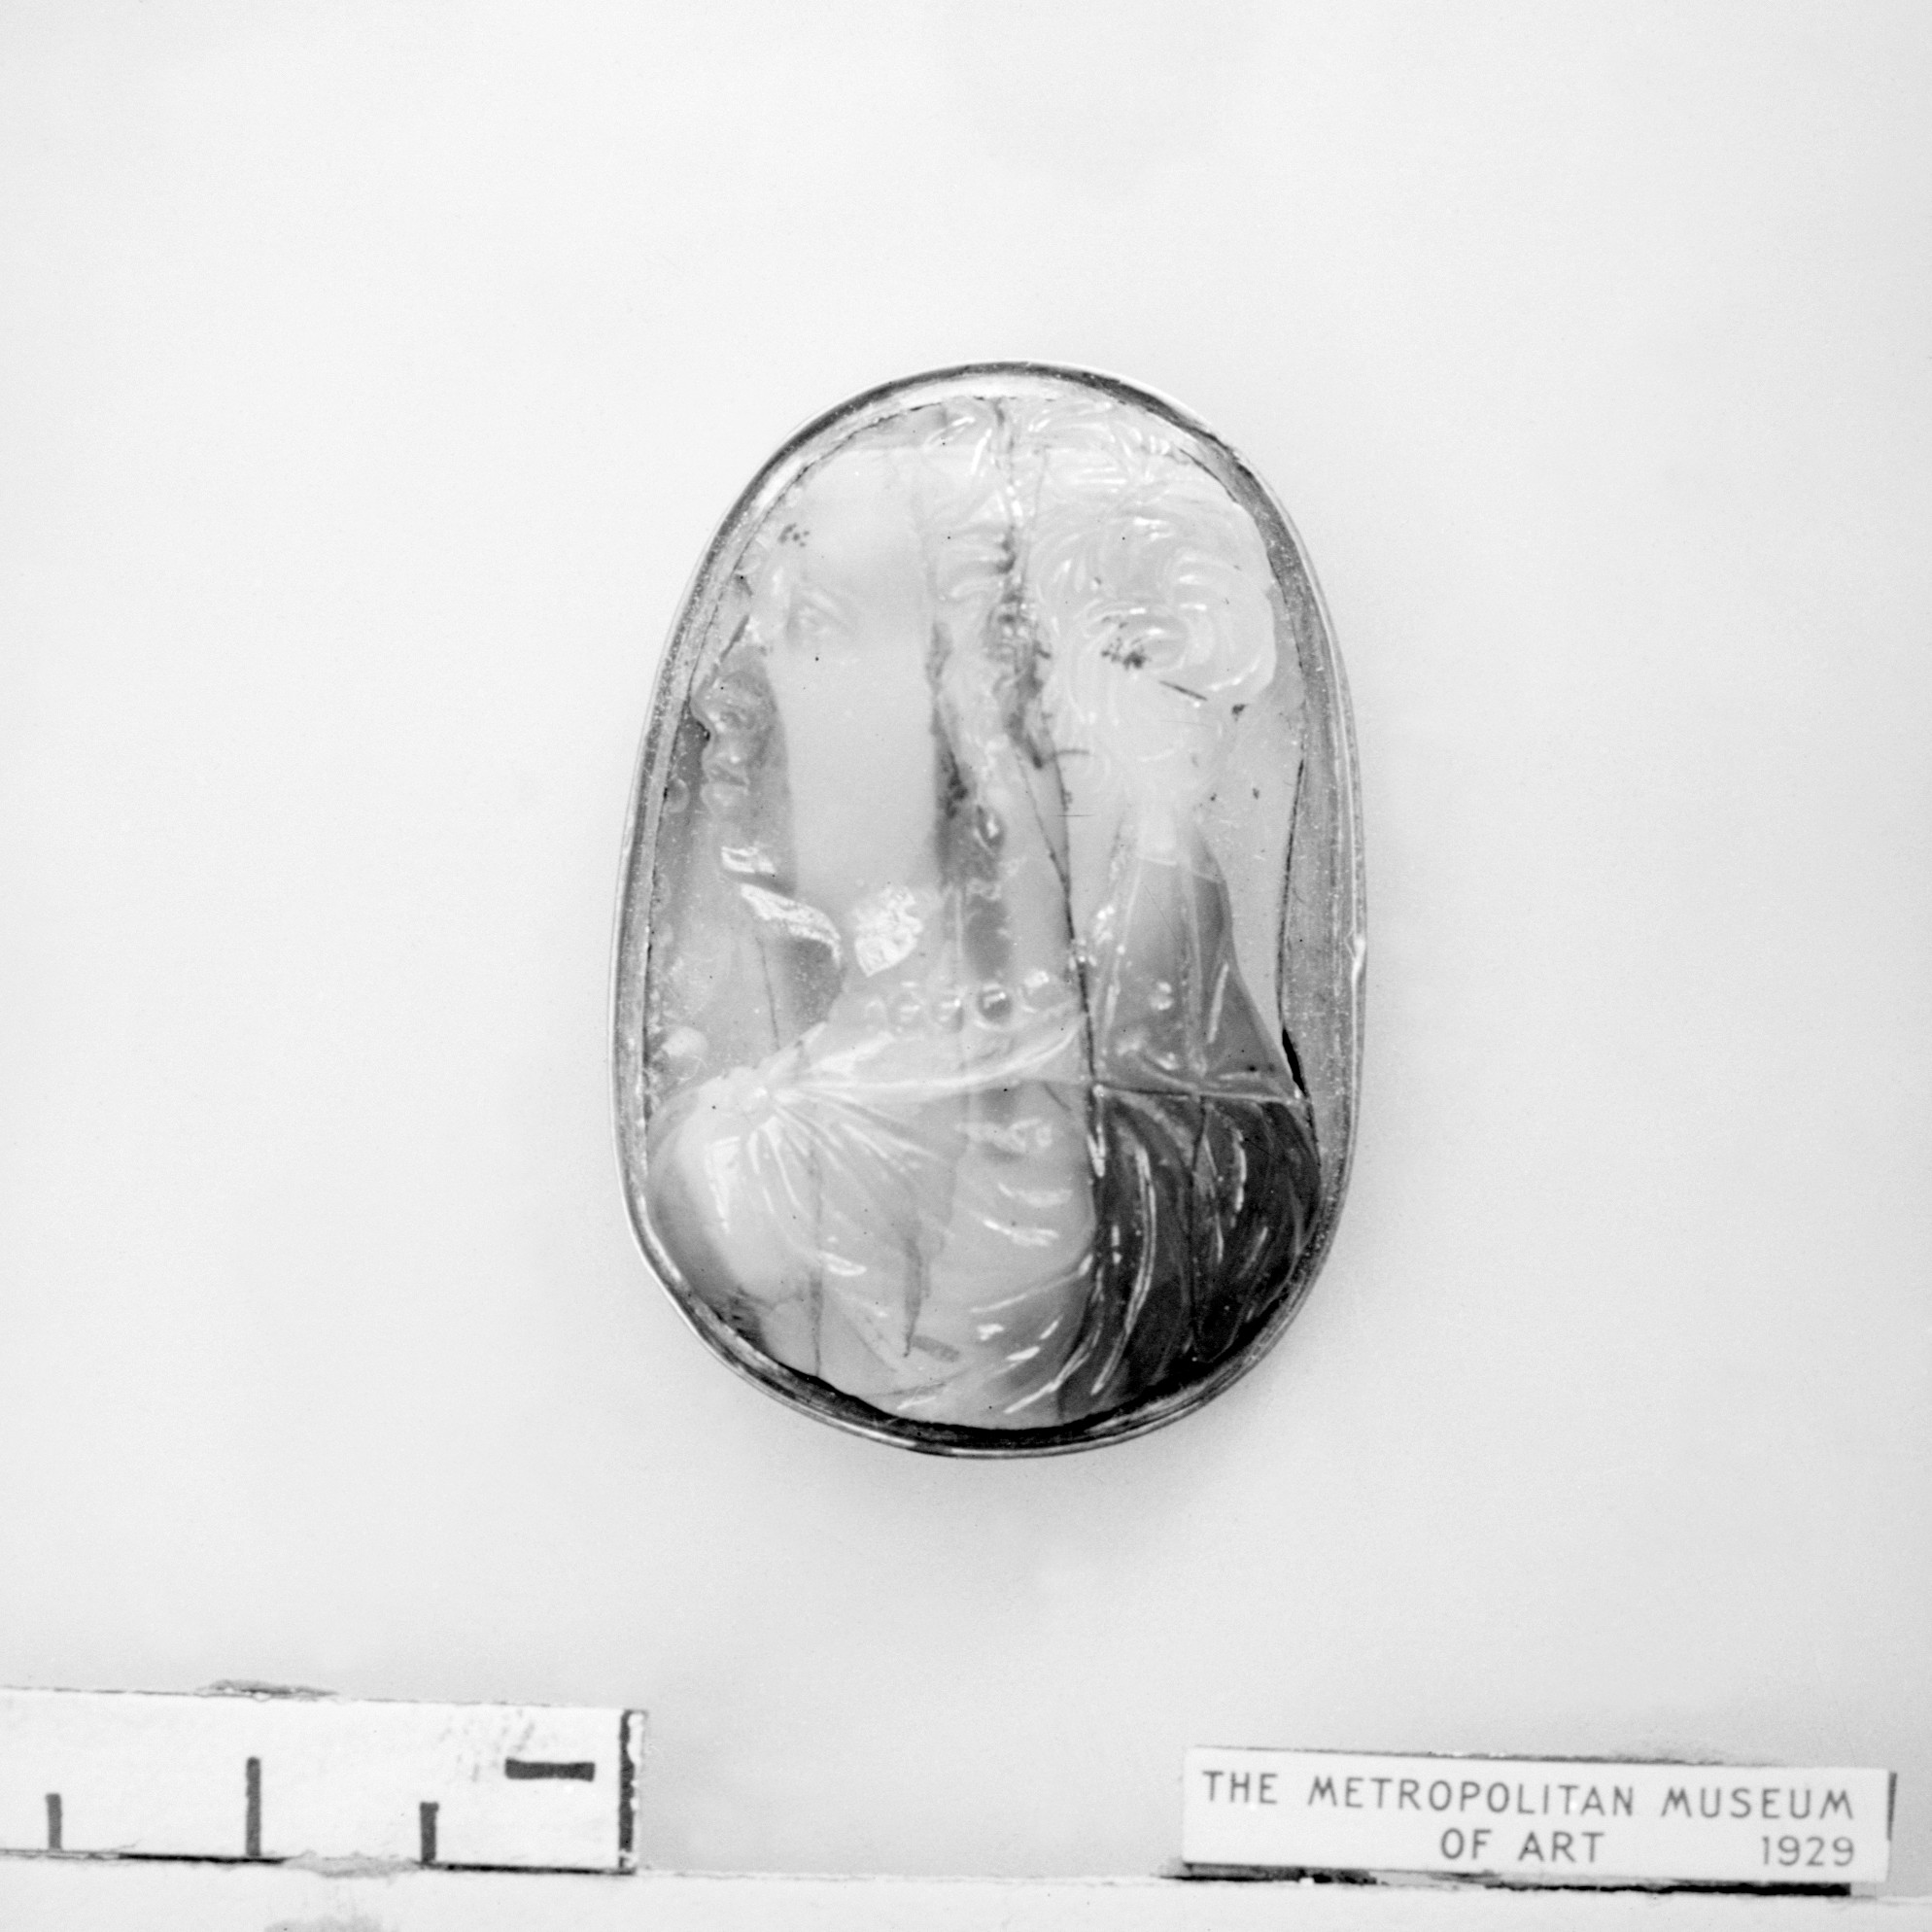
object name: cameo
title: Portrait of a lady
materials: stone, gold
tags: profiles,women